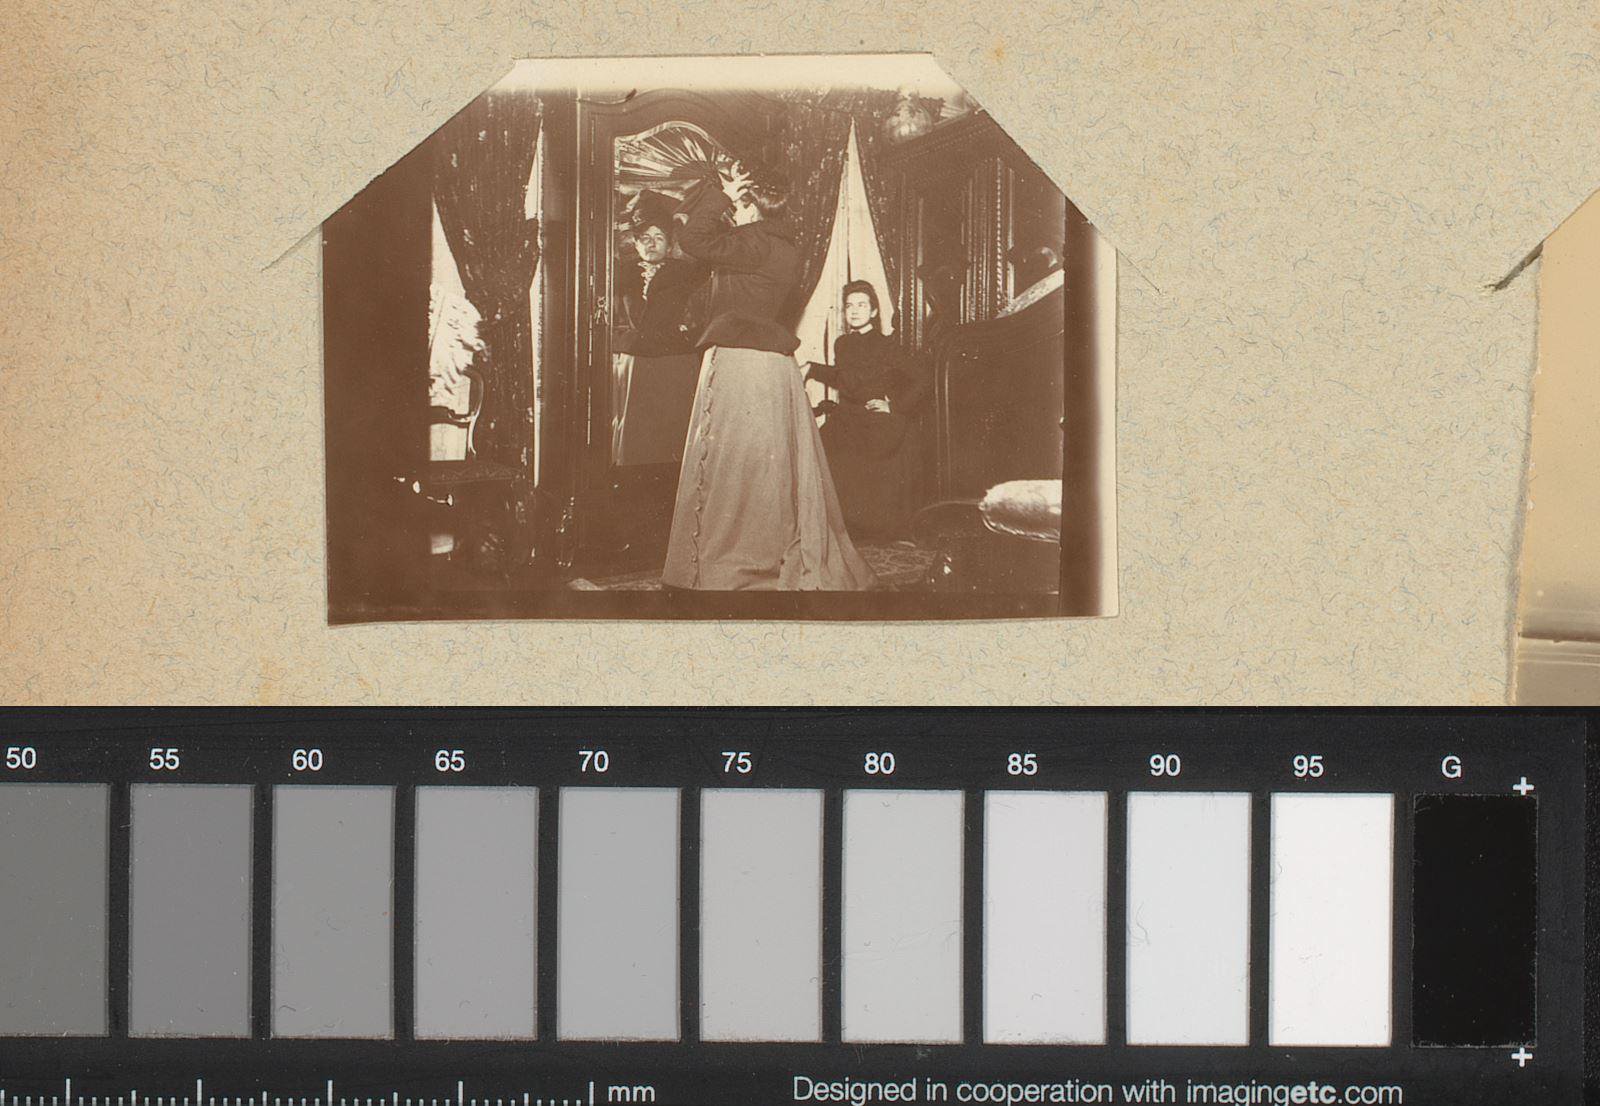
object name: album leaf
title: Vrouw staand voor een spiegel, een andere vrouw kijkt toe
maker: Anonymous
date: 1897-1900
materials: paper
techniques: gelatin silver print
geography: france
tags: adult woman, dressing oneself, getting dressed - aa - female human figure, france